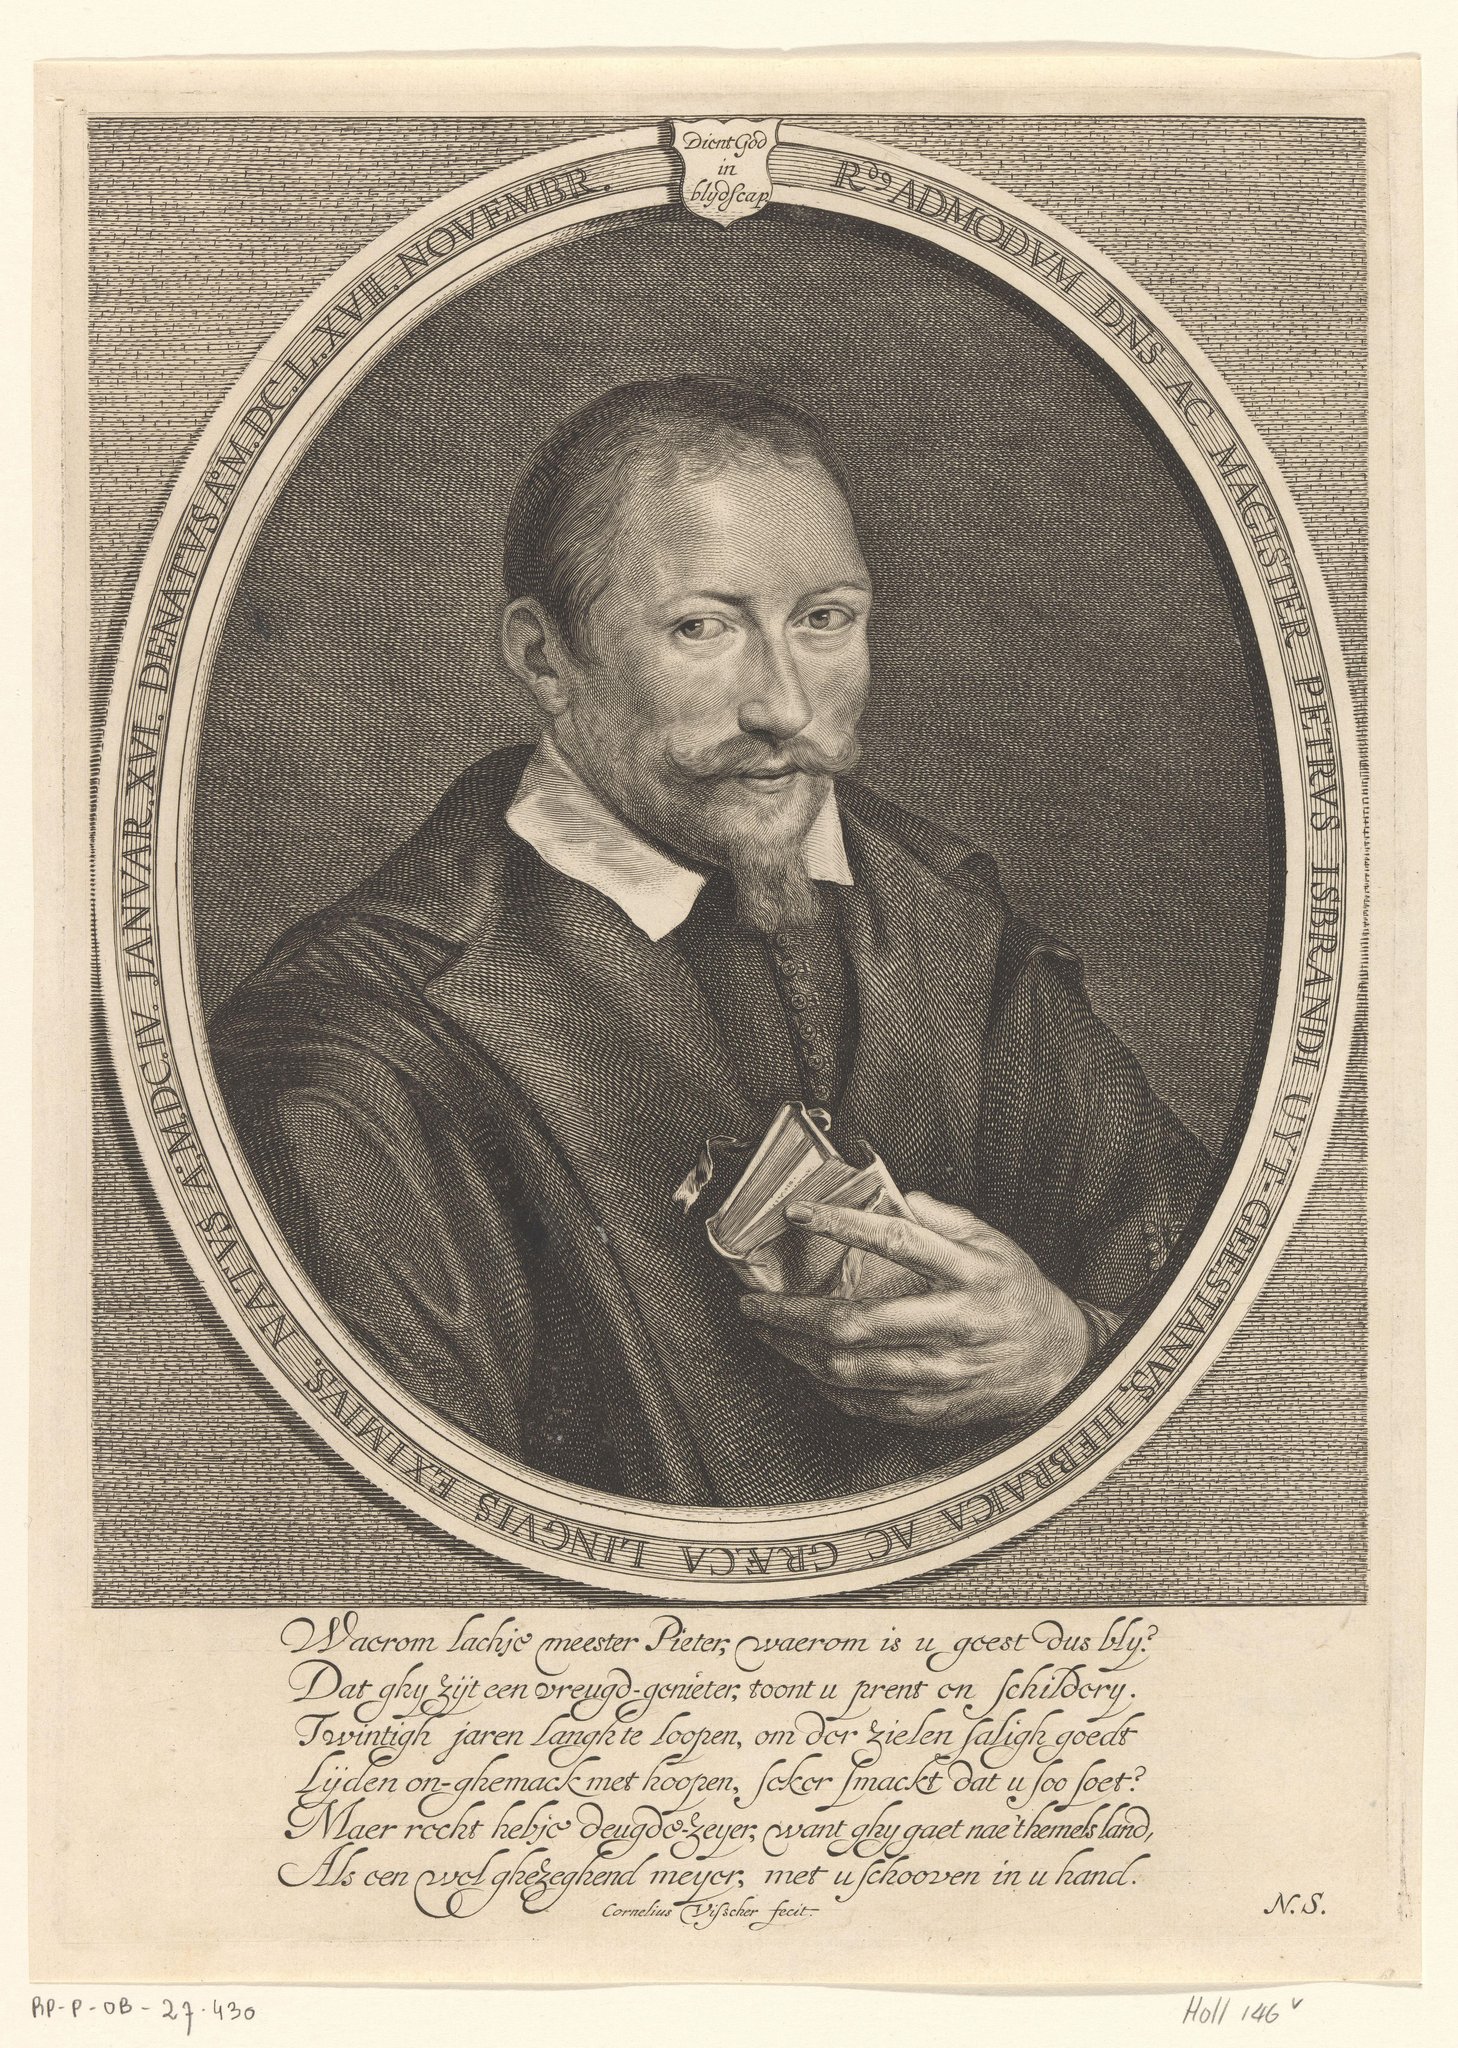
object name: print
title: Portret van Pieter Isbrandi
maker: nicolaas stenius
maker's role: schrijver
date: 1638-1658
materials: paper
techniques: engraving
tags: book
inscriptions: collector's mark: Lugt 240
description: Pieter Isbrandi met in zijn hand een boek. In de marge een lofdicht.